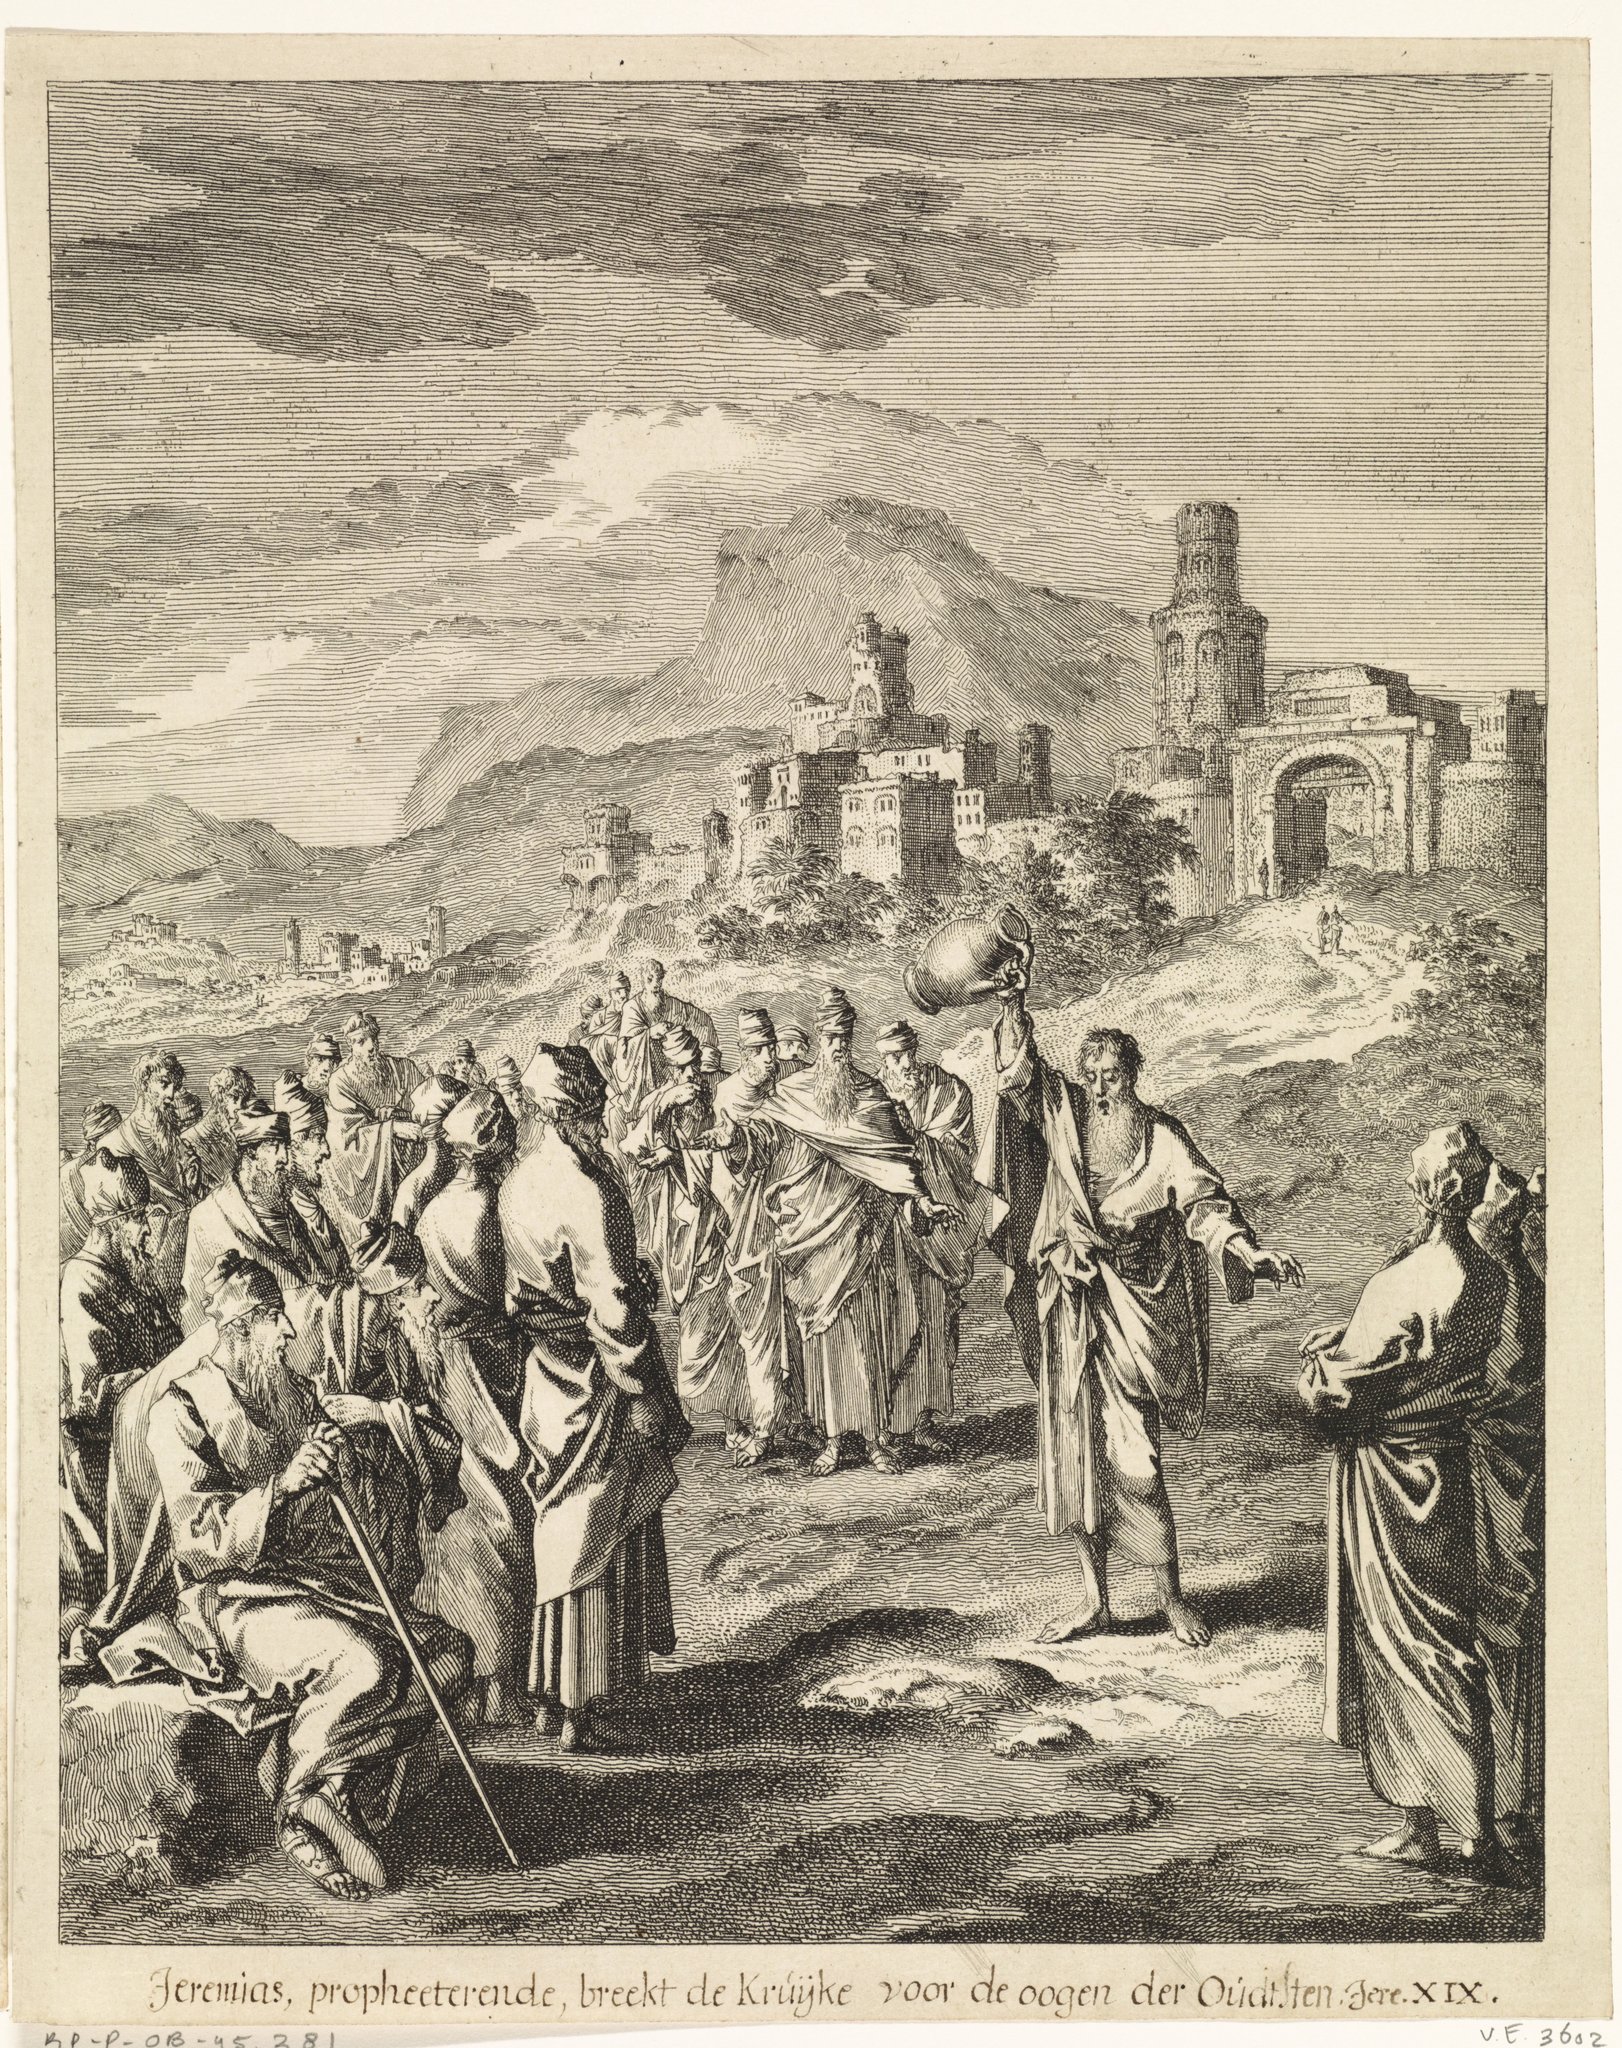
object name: print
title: Jeremia breekt de kruik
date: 1708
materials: paper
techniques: etching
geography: amsterdam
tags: the parable of the broken earthen bottle before the gate of jerusalem (jeremiah 19:1-13)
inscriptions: collector's mark: Lugt 2228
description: Proefdruk van een prent welke is opgenomen als illustratie in: Historiae Celebriores Veteris Testamenti. Christoph Weigel, 1708.